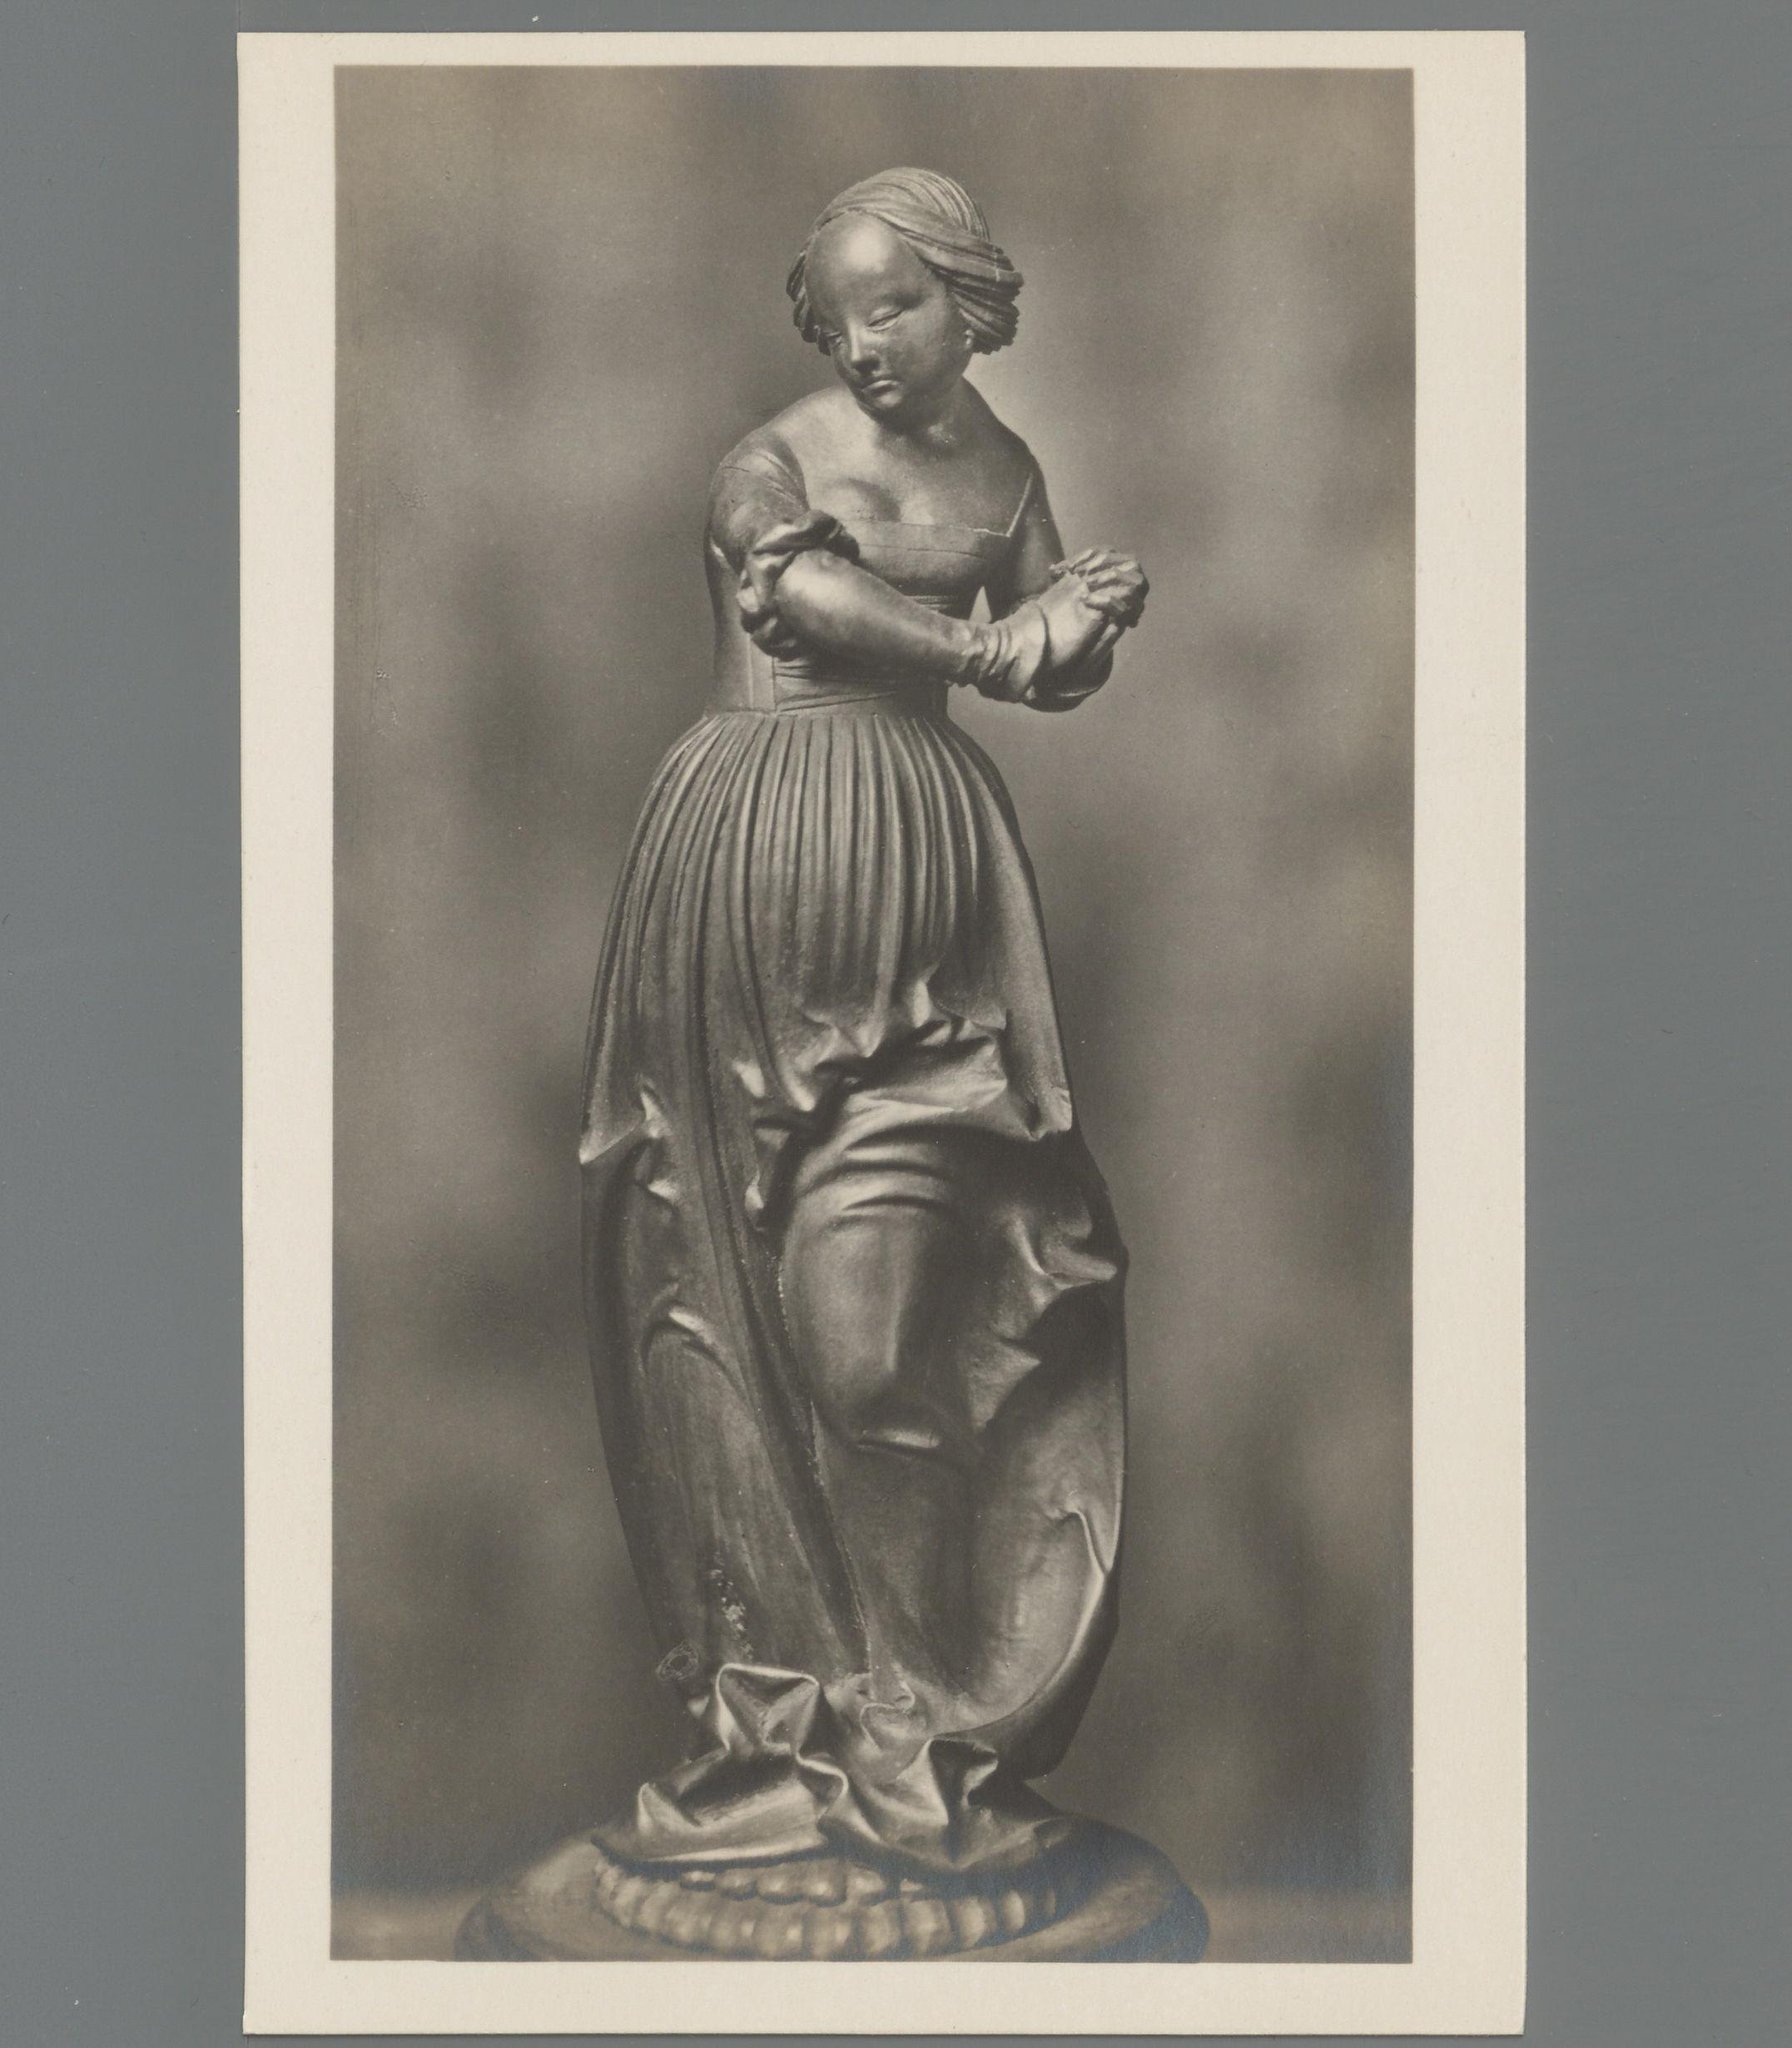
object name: ansichtkaart, prentbriefkaart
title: Kaiser-Friedrich-Museum Berlin. Die hl. Barbara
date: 1904-1930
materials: photographic support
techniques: photography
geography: berlin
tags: statues, paintings, etc. ~ objects of worship in roman religion, permanent exhibition, museum